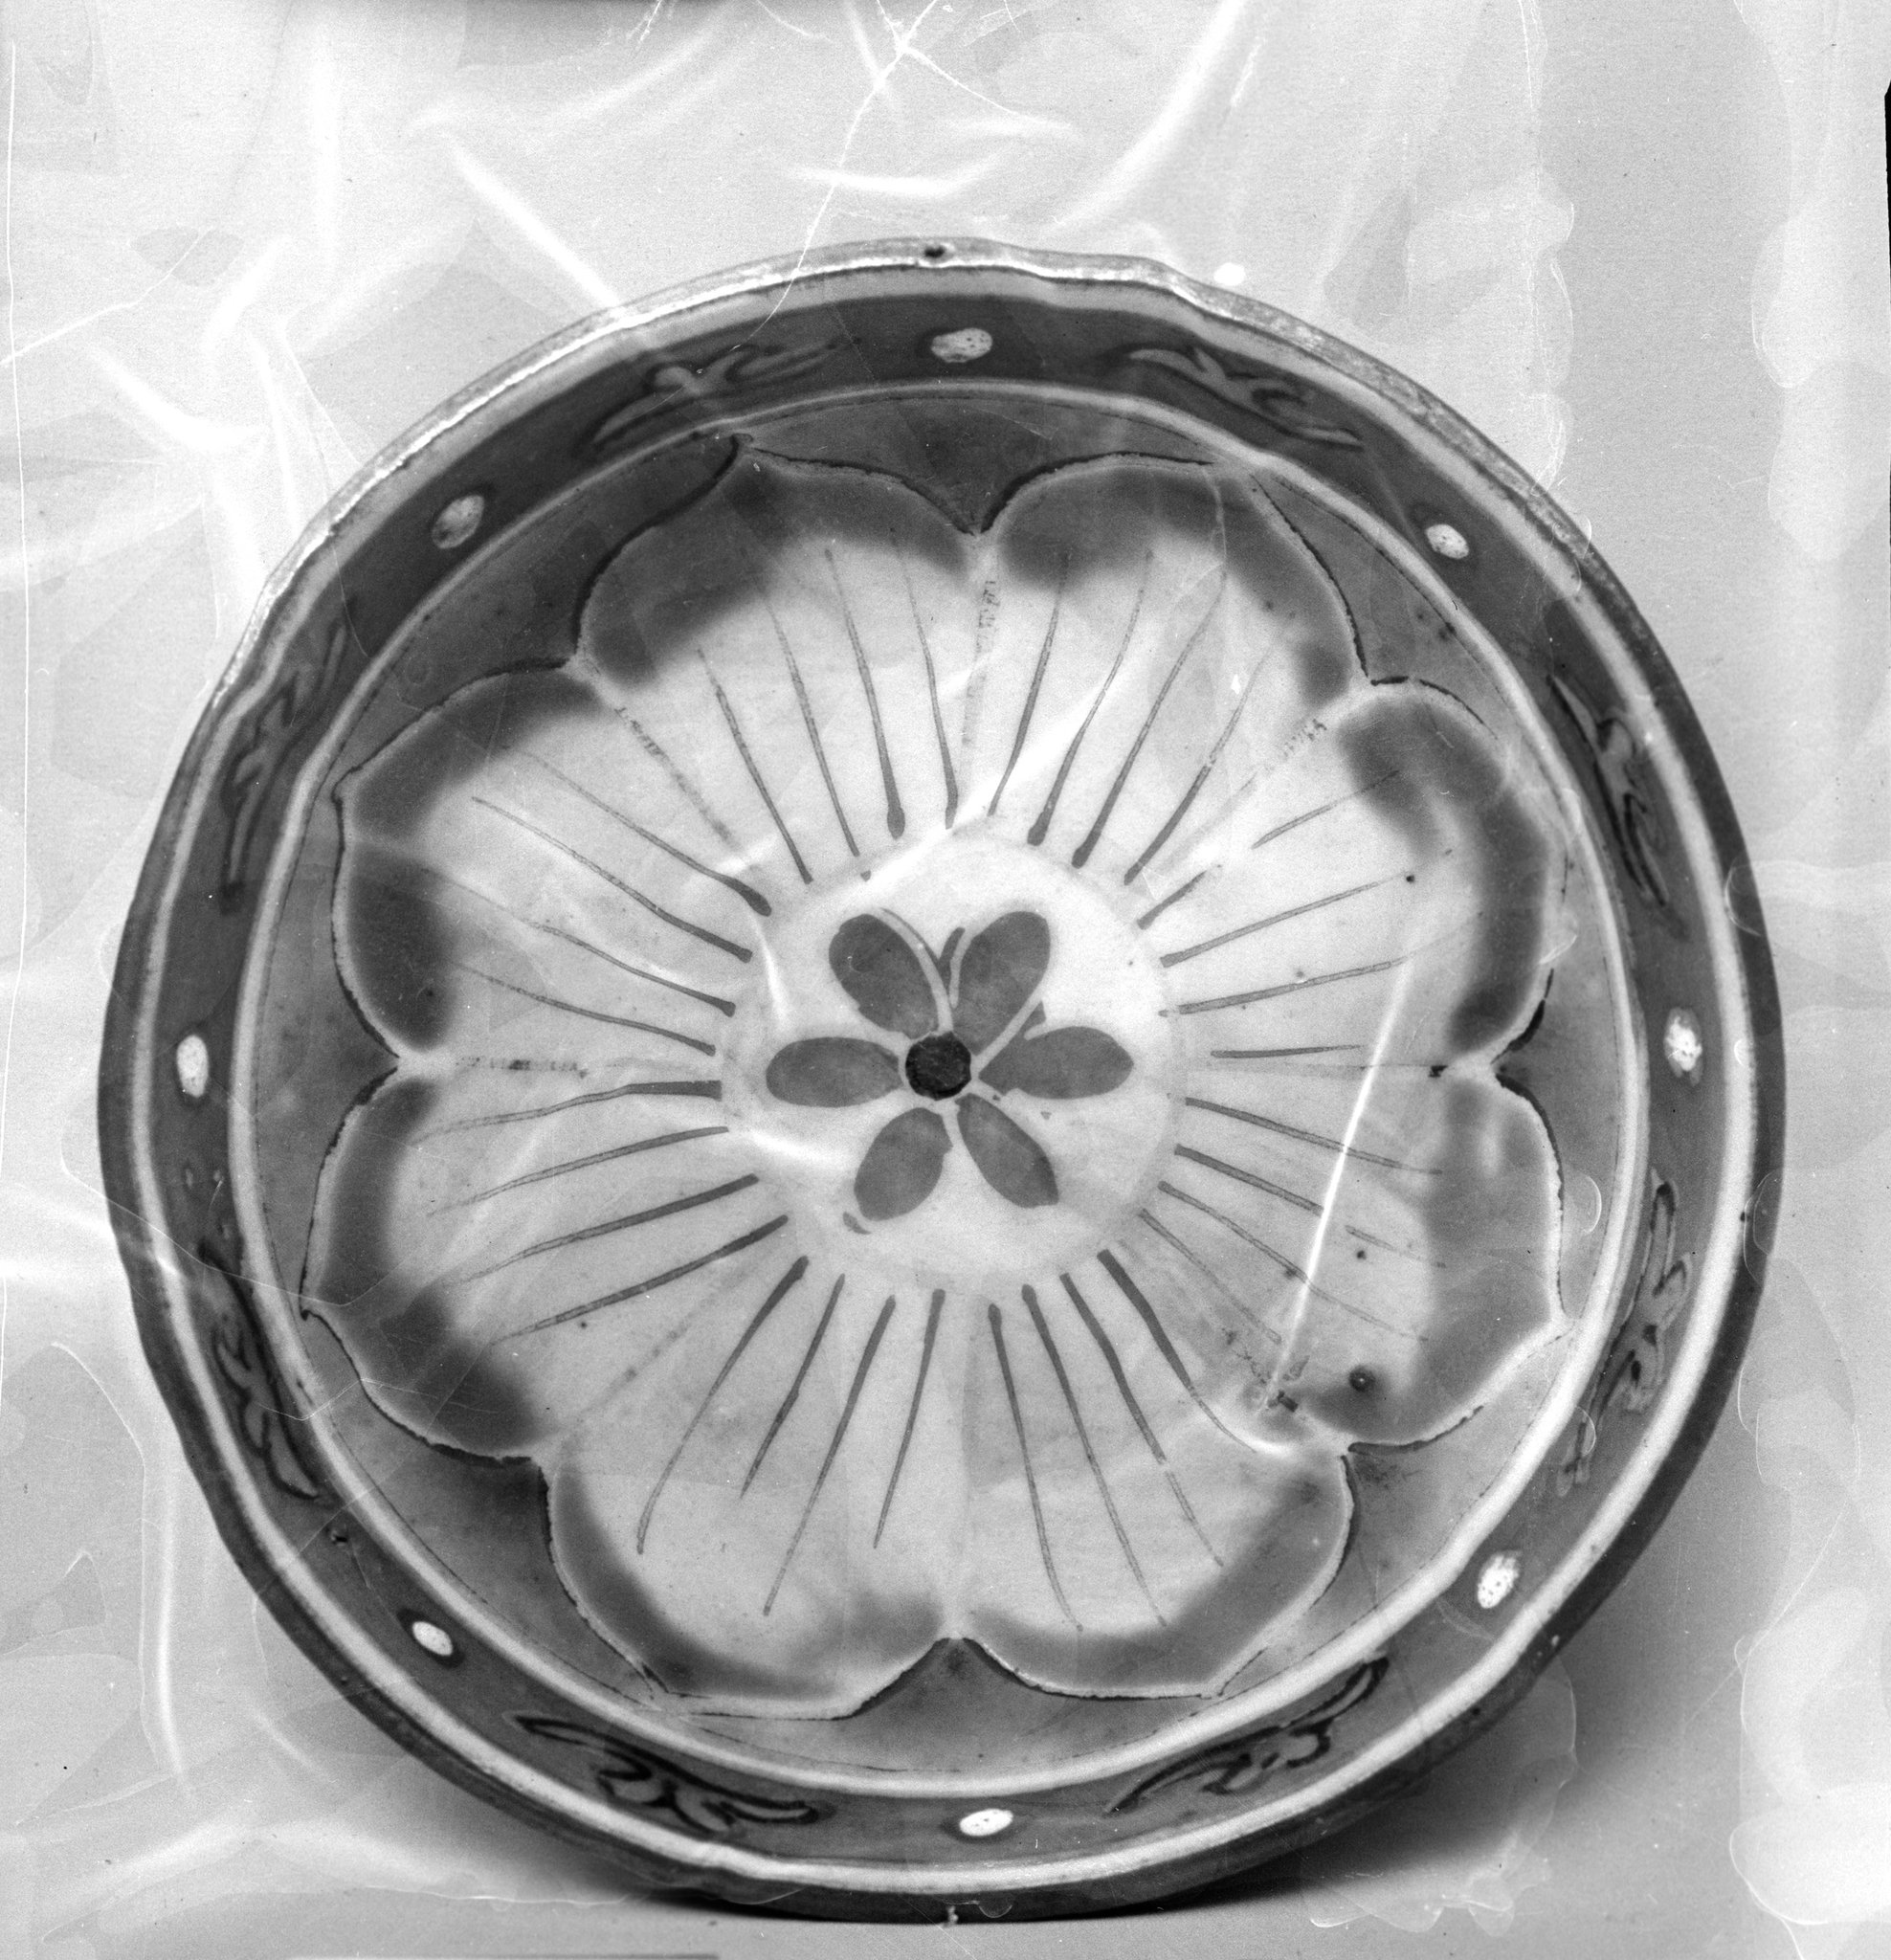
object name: saucer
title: Saucer with floral pattern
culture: chinese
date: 1801-1900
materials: enamel, porcelain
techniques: overglaze, painting, polychrome